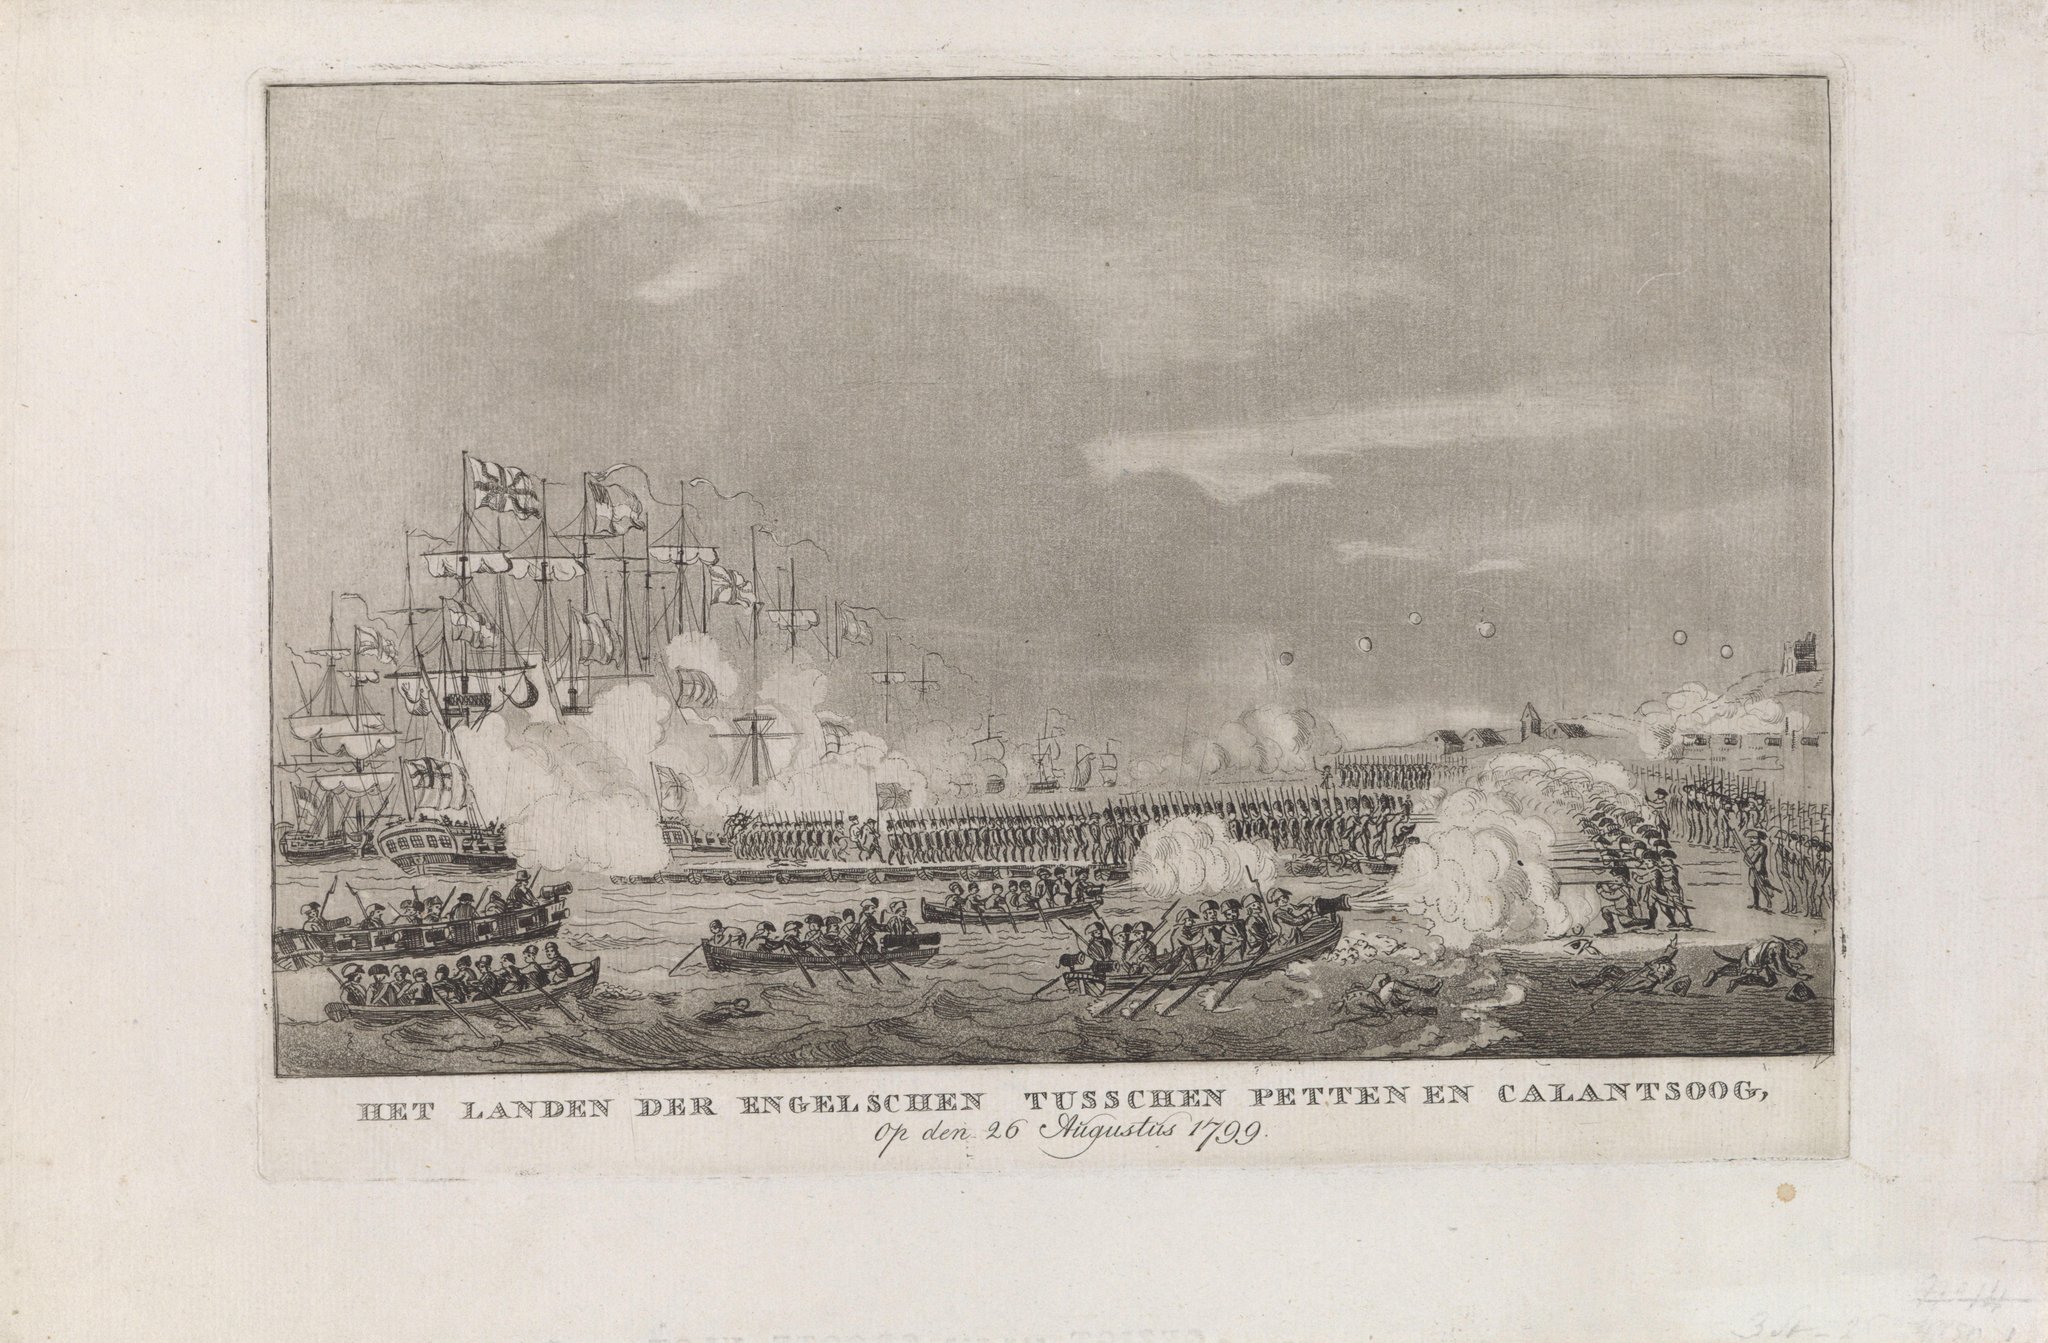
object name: print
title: Het Landen der Engelschen tusschen Petten en Calantsoog, op den 26 Augustus 1799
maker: Anonymous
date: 1799-1800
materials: paper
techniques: aquatint, etching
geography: netherlands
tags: (military) attack, pontoon bridge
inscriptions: inscription: ‘Gezigt van het Groote Vlot te St. Malo’, collector's mark: Lugt 2228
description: De landing van de Britse invasiemacht aan de kust bij Callantsoog, 27 augustus 1799. Troepen komen met sloepen en over een schipbrug naar de kust. Vanaf het strand vuren de Bataafse soldaten op de landingstroepen. Zie ook de pendant.